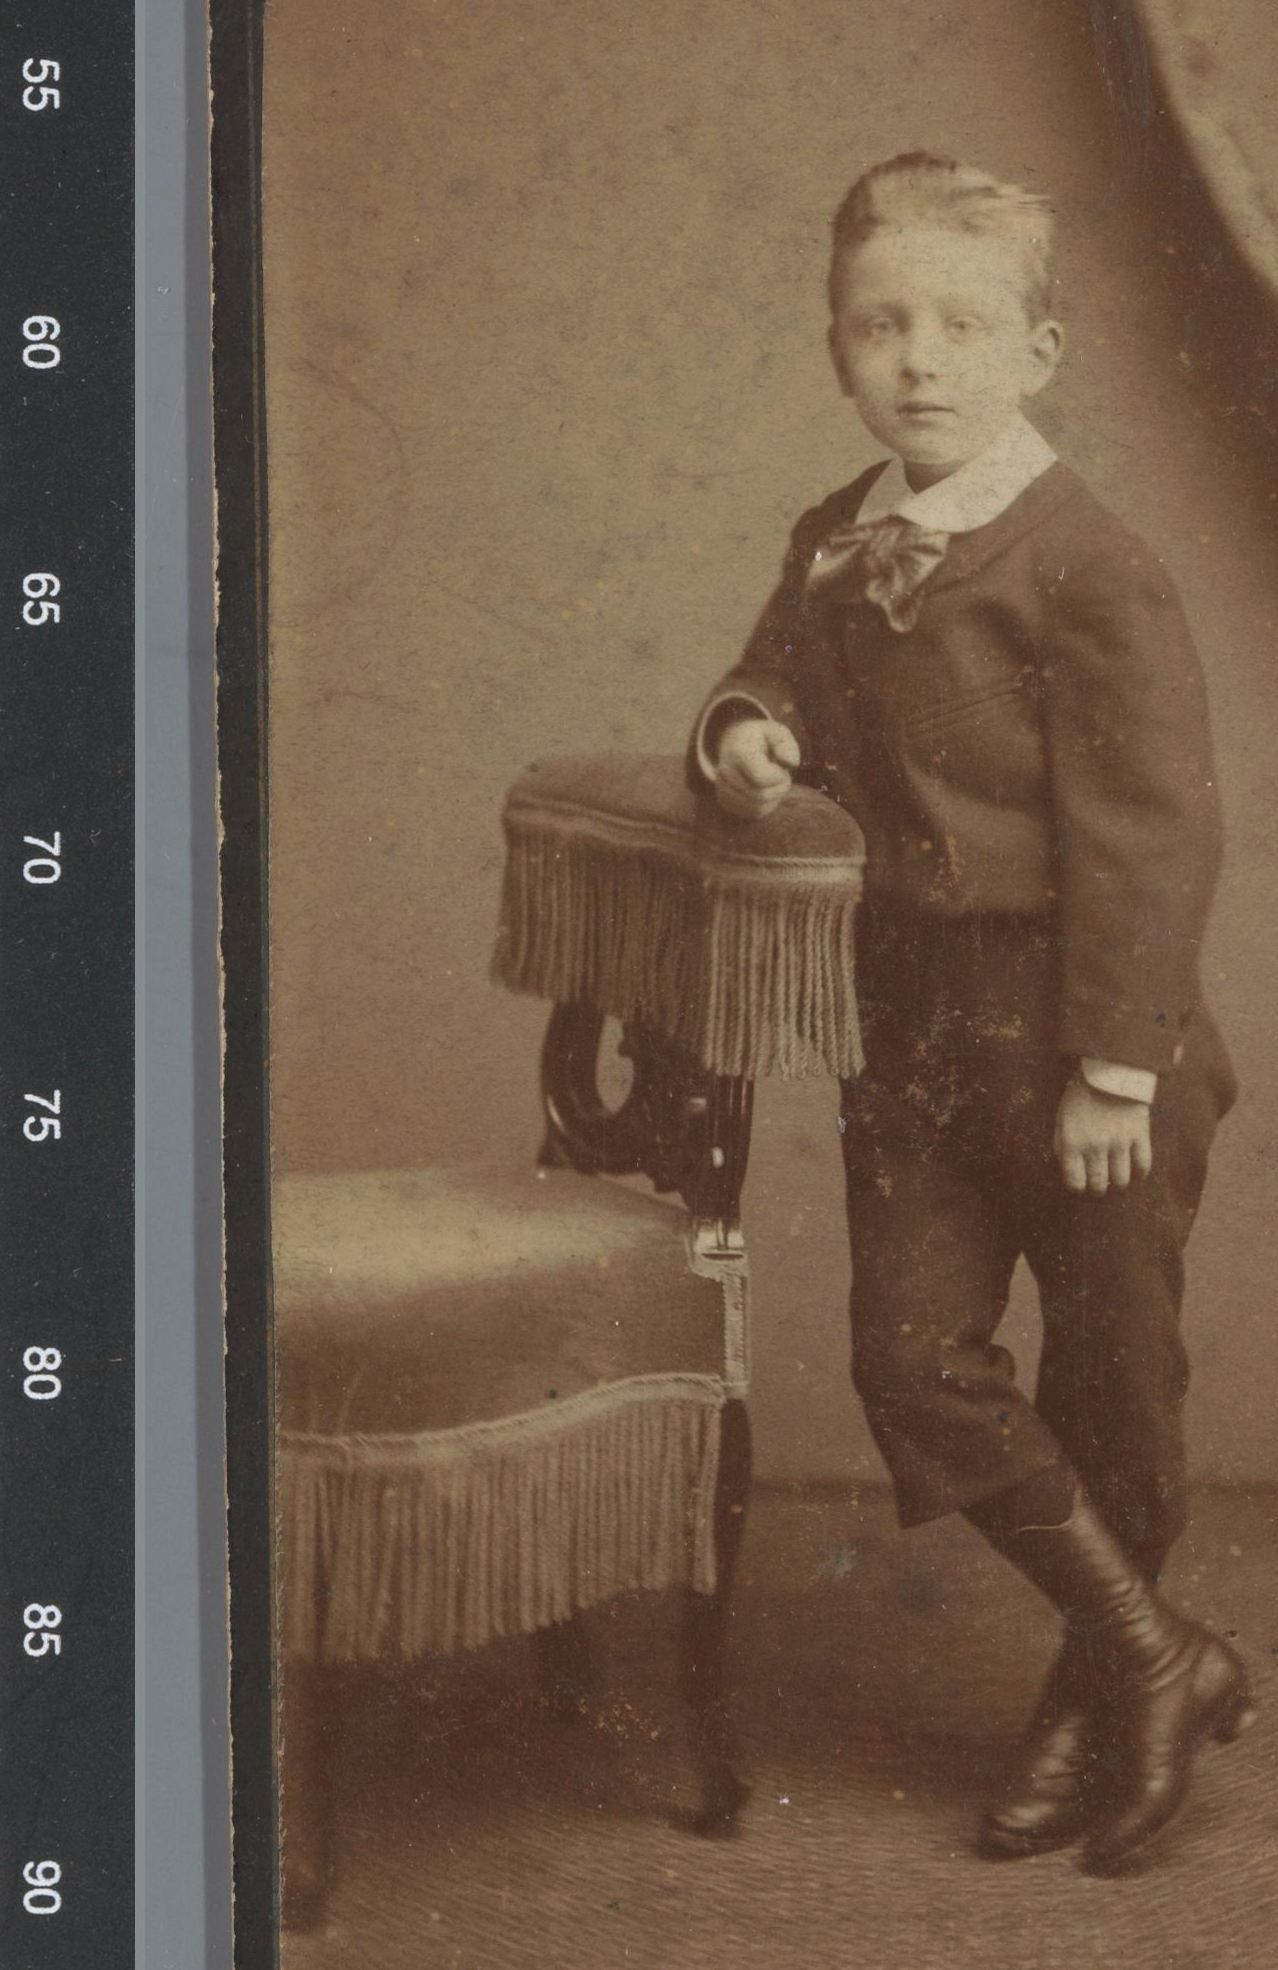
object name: carte de visite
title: Portret van een onbekende jongen naast een stoel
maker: jacob kuyper (1851-1919)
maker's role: fotograaf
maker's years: 1851-1919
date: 1878-1885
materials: cardboard, paper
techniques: albumen print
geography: zaandam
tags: boy (child between toddler and youth), anonymous historical person portrayed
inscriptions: inscription: ‘[...] J. Breebaard/ [...]’